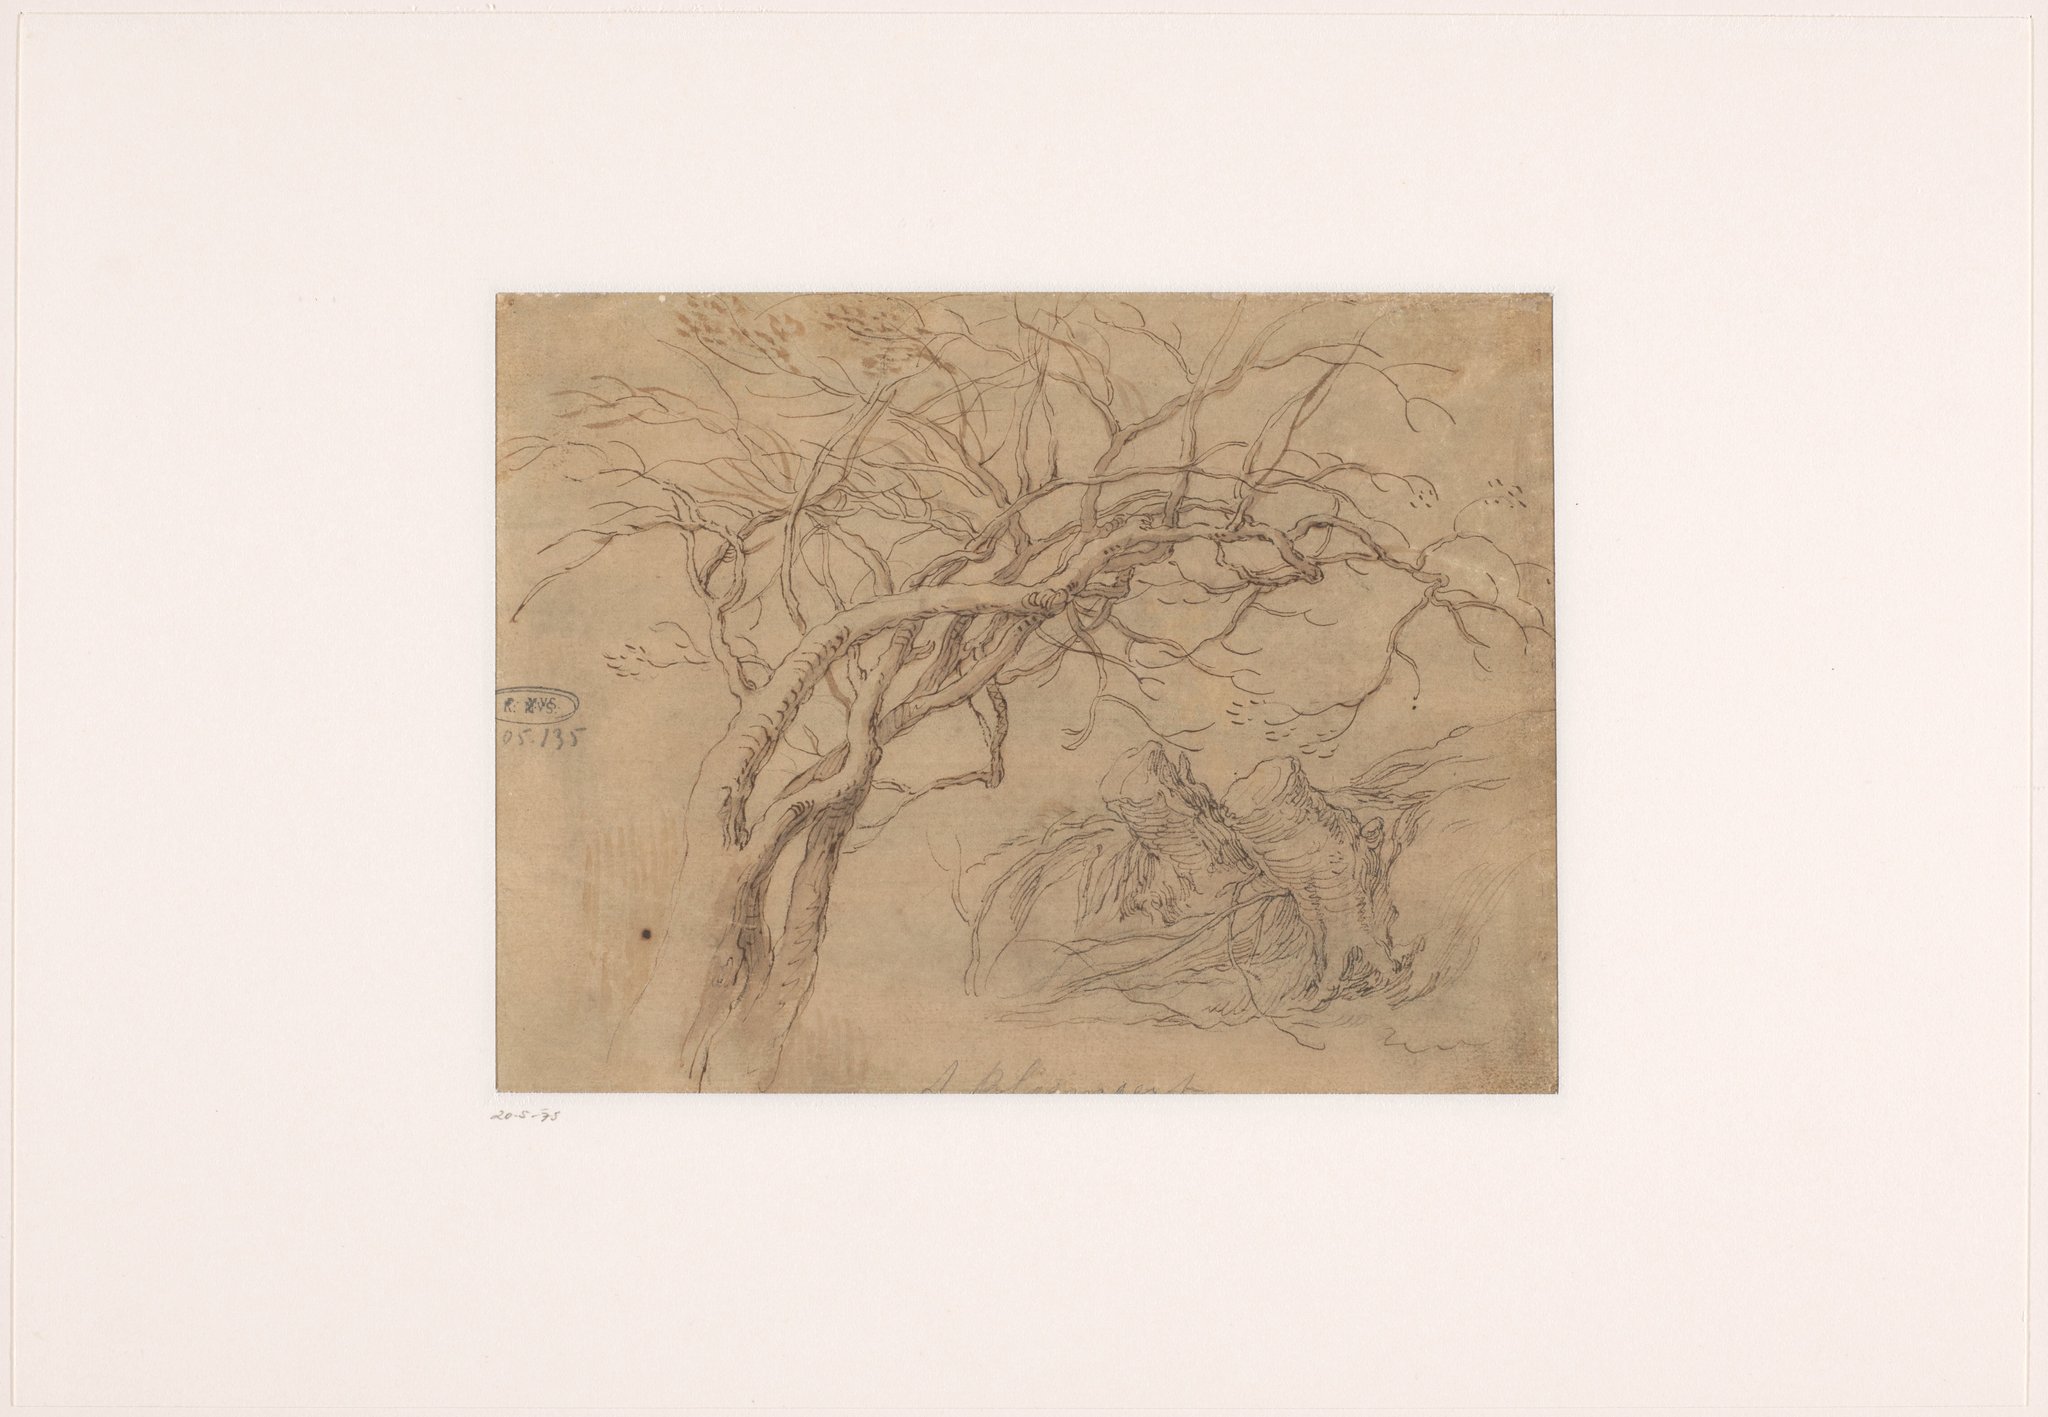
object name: drawing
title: Studies van boomtakken en boomstronken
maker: abraham bloemaert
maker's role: draughtsman, painter, print maker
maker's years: 1566-1651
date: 1625-1629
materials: chalk, ink, paper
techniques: pen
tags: trees, trees (+ branch, stick)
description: Afkomstig uit een schetsboek van 43 (?) bladen.